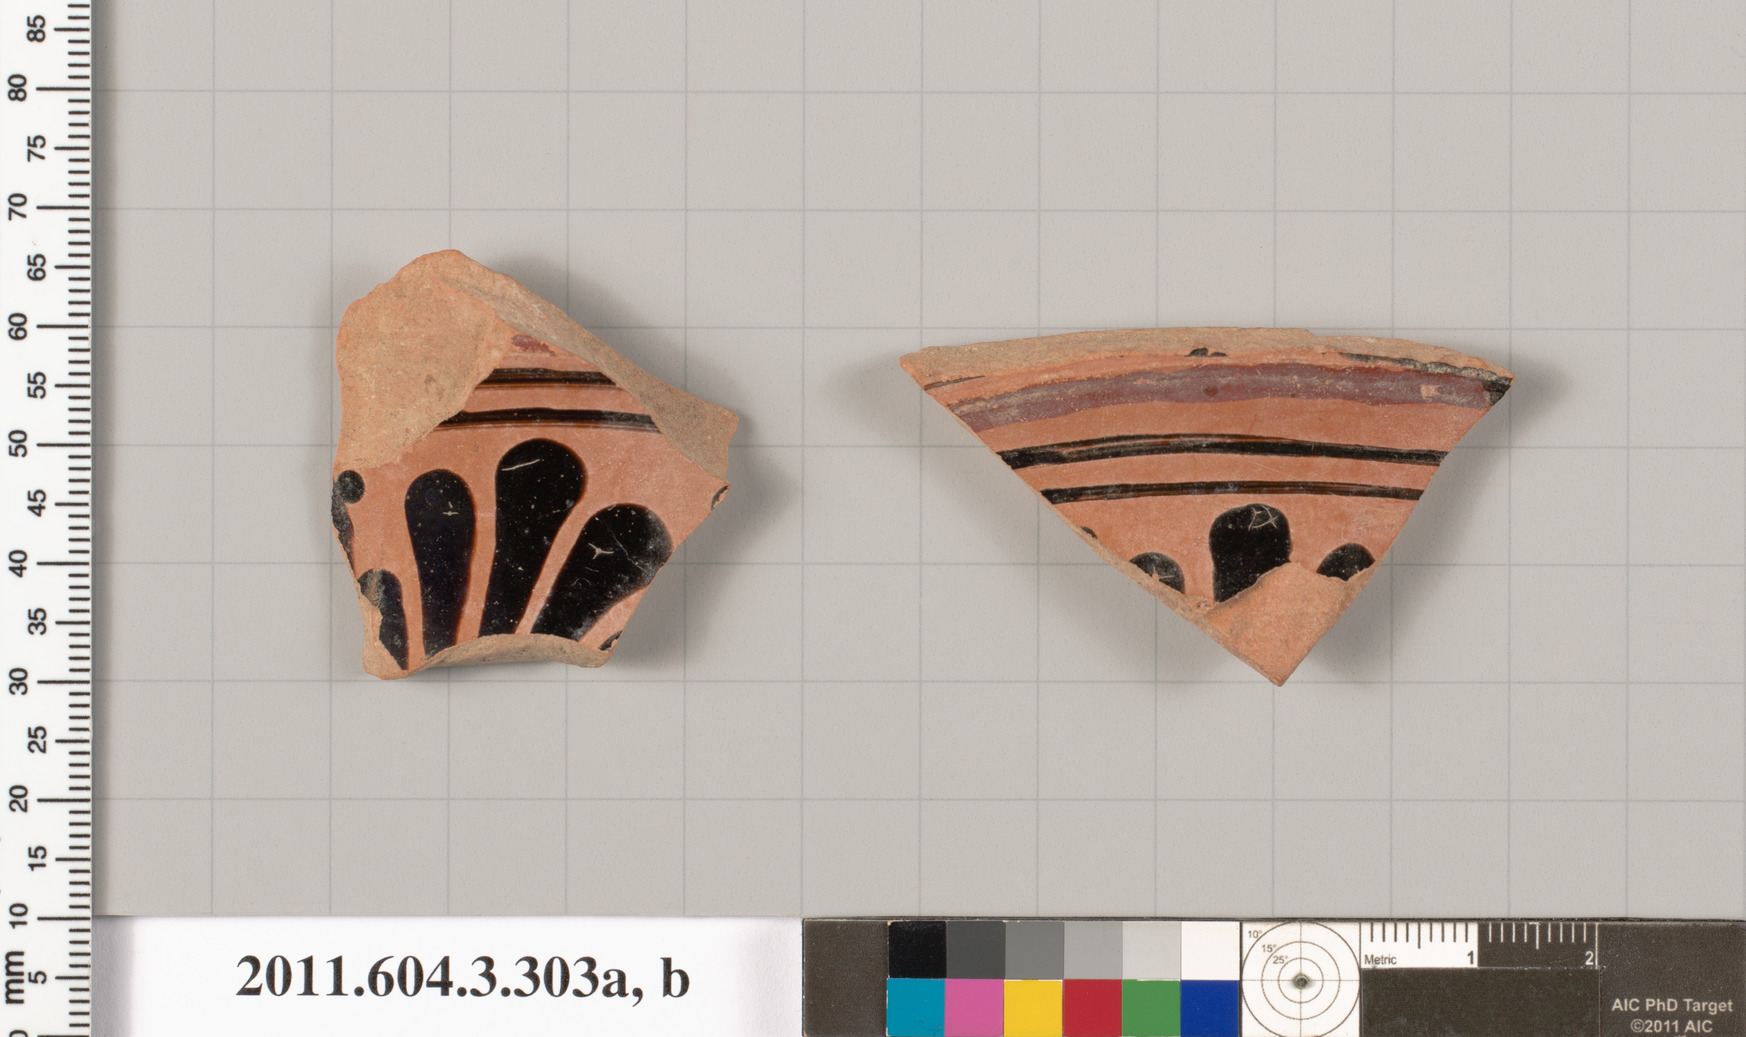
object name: neck amphora fragment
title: Terracotta fragments of a neck-amphora (jar)?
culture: greek, attic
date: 500-468 BCE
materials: terracotta